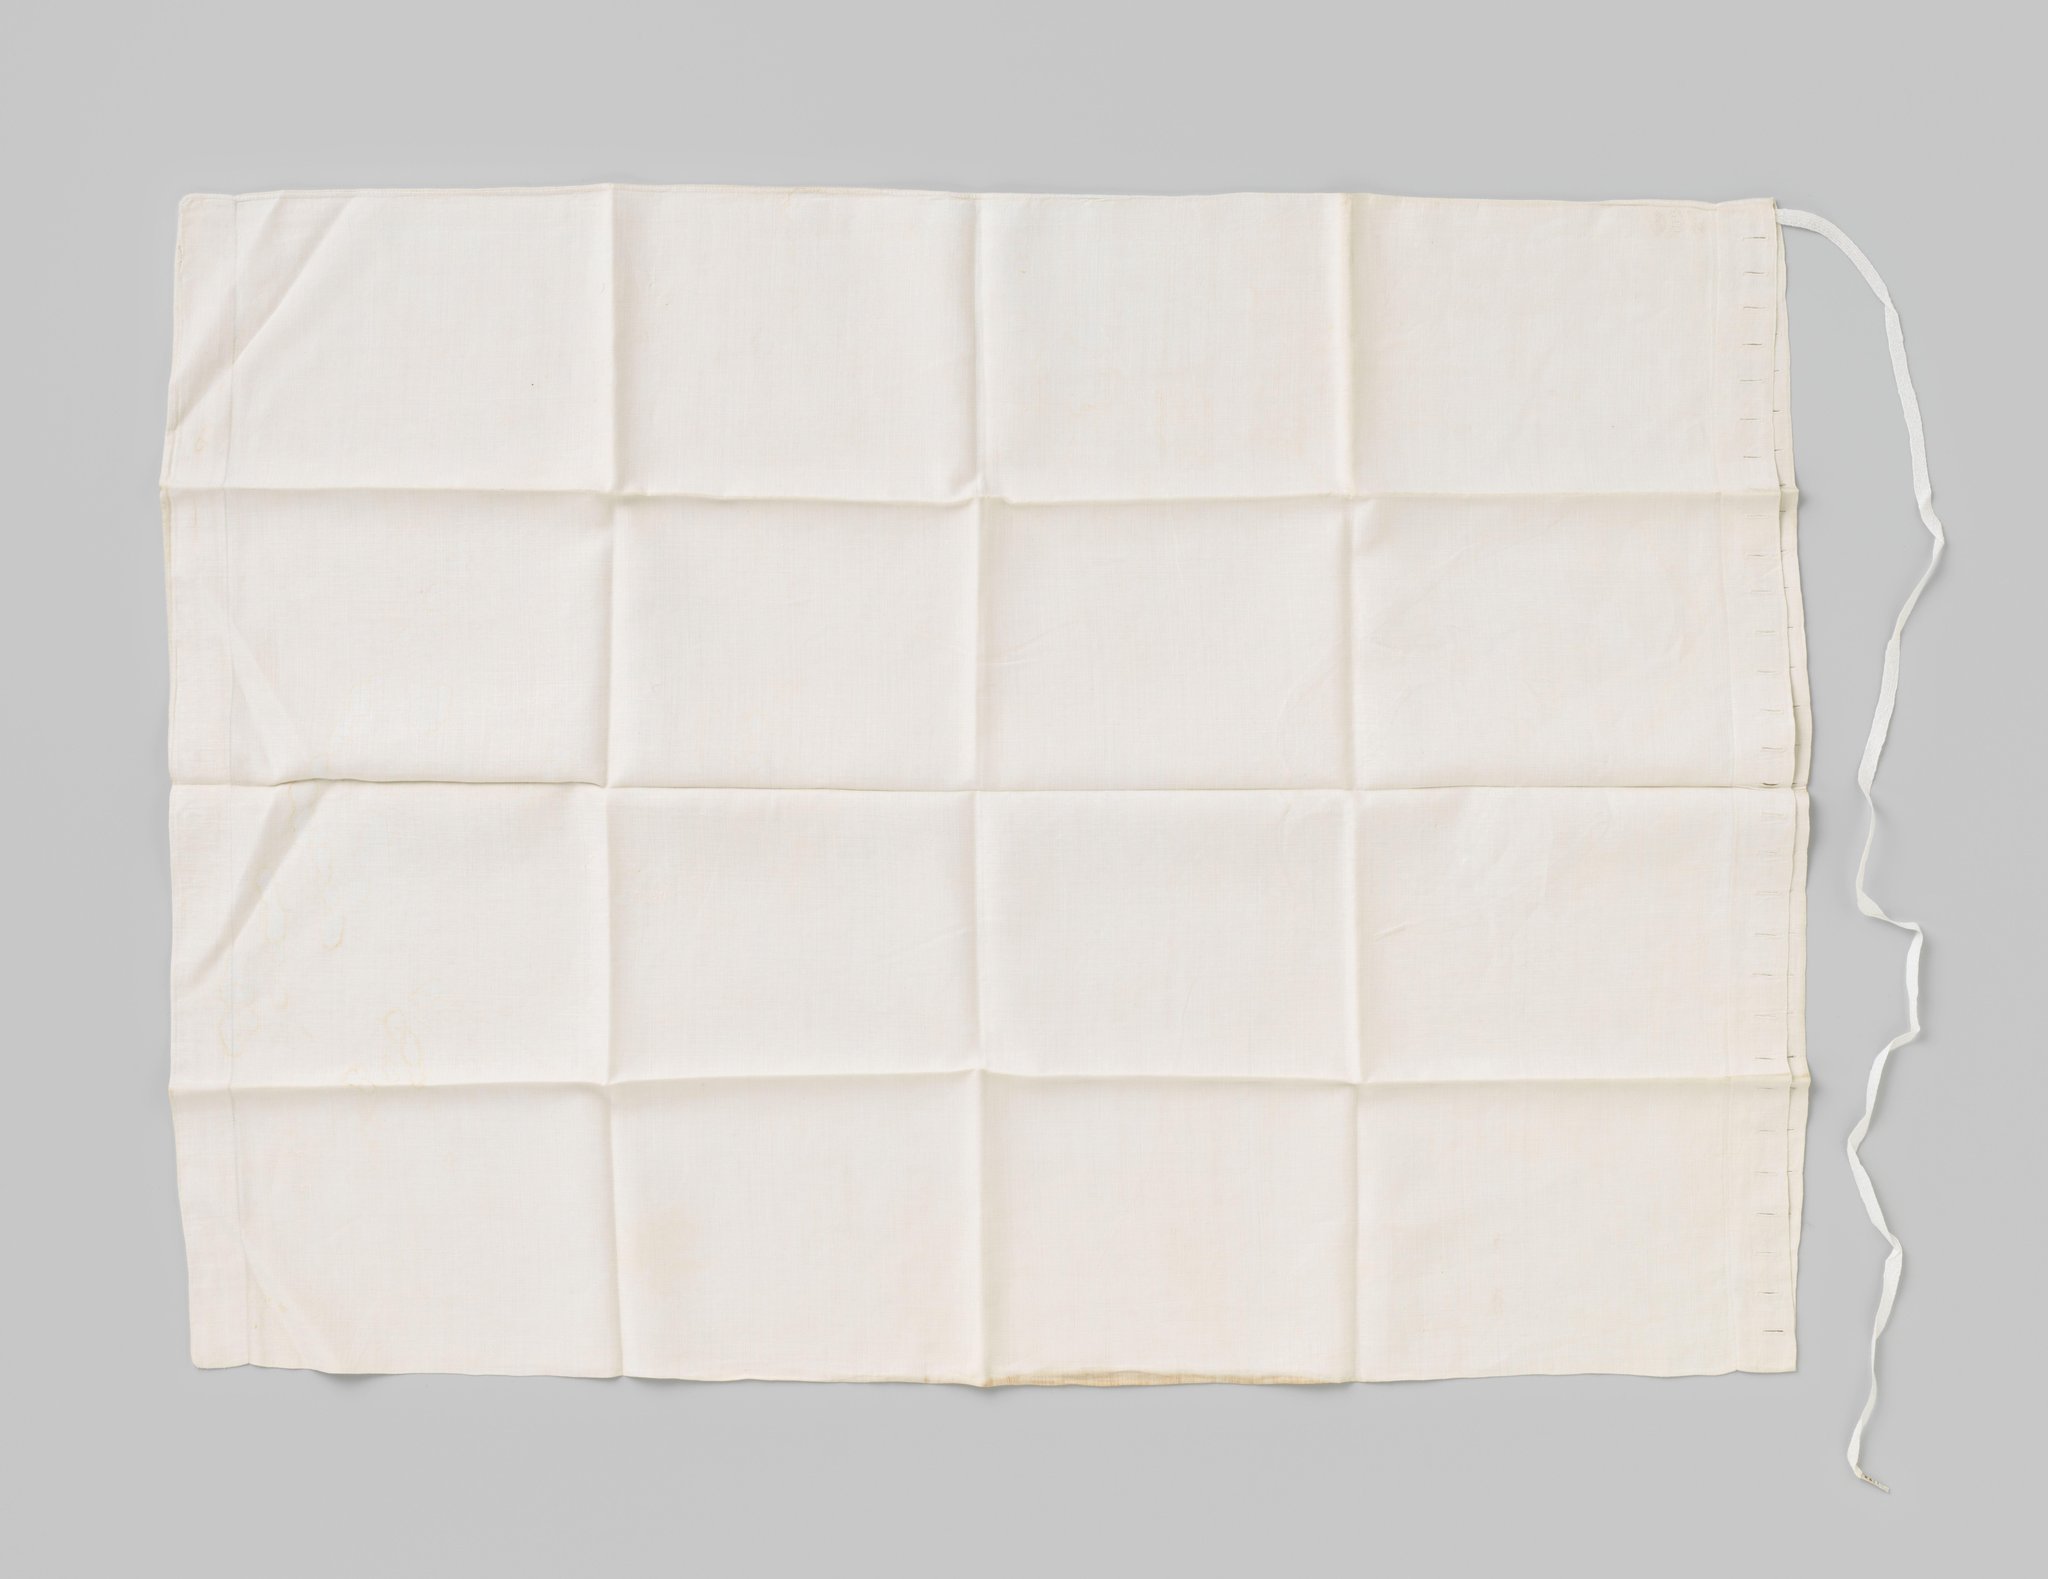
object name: pillowcase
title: Wit kussensloop van linnen, gemerkt kroon WG 24 en 1737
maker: Anonymous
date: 1737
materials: linen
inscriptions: mark: ‘1737’, mark: ‘kroon WQ 24’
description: Wit kussensloop van linnen. In een hoek gatenmerk kroon WG 24, in een andere hoek "1737" geborduurd in wit. Koordsluiting.